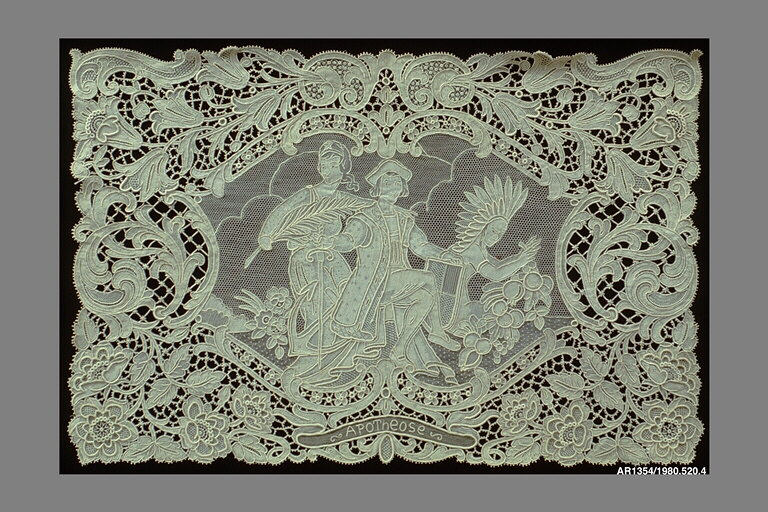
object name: mat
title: Mat (from a set of table linens)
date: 1867-1900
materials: linen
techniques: lace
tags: men,women,flowers